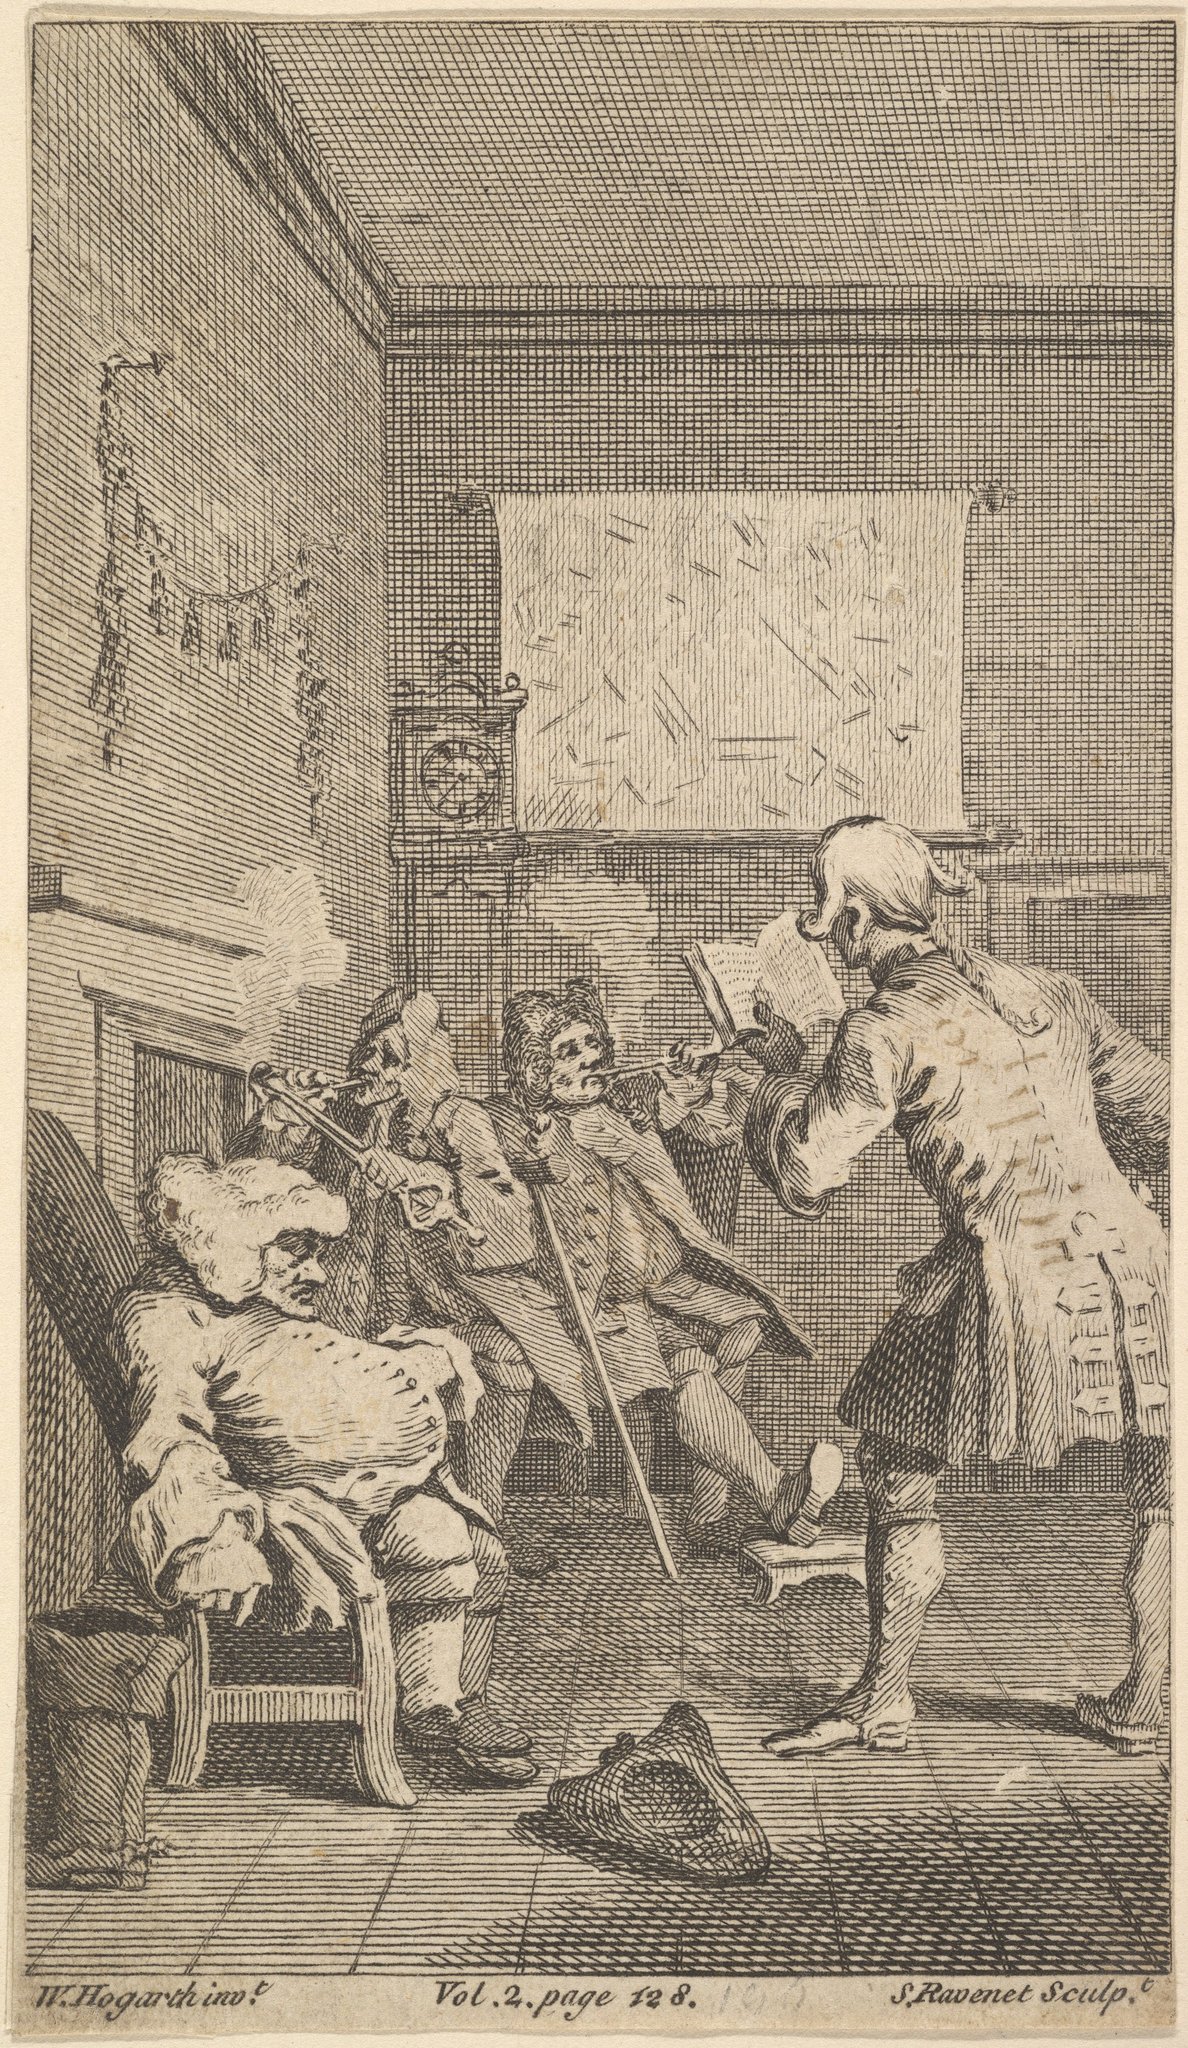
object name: print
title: "Tristram Shandy," Frontispiece, Volume 1,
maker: william hogarth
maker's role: artist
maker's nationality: british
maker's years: 1697-1764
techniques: engraving, etching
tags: men,reading,smoking